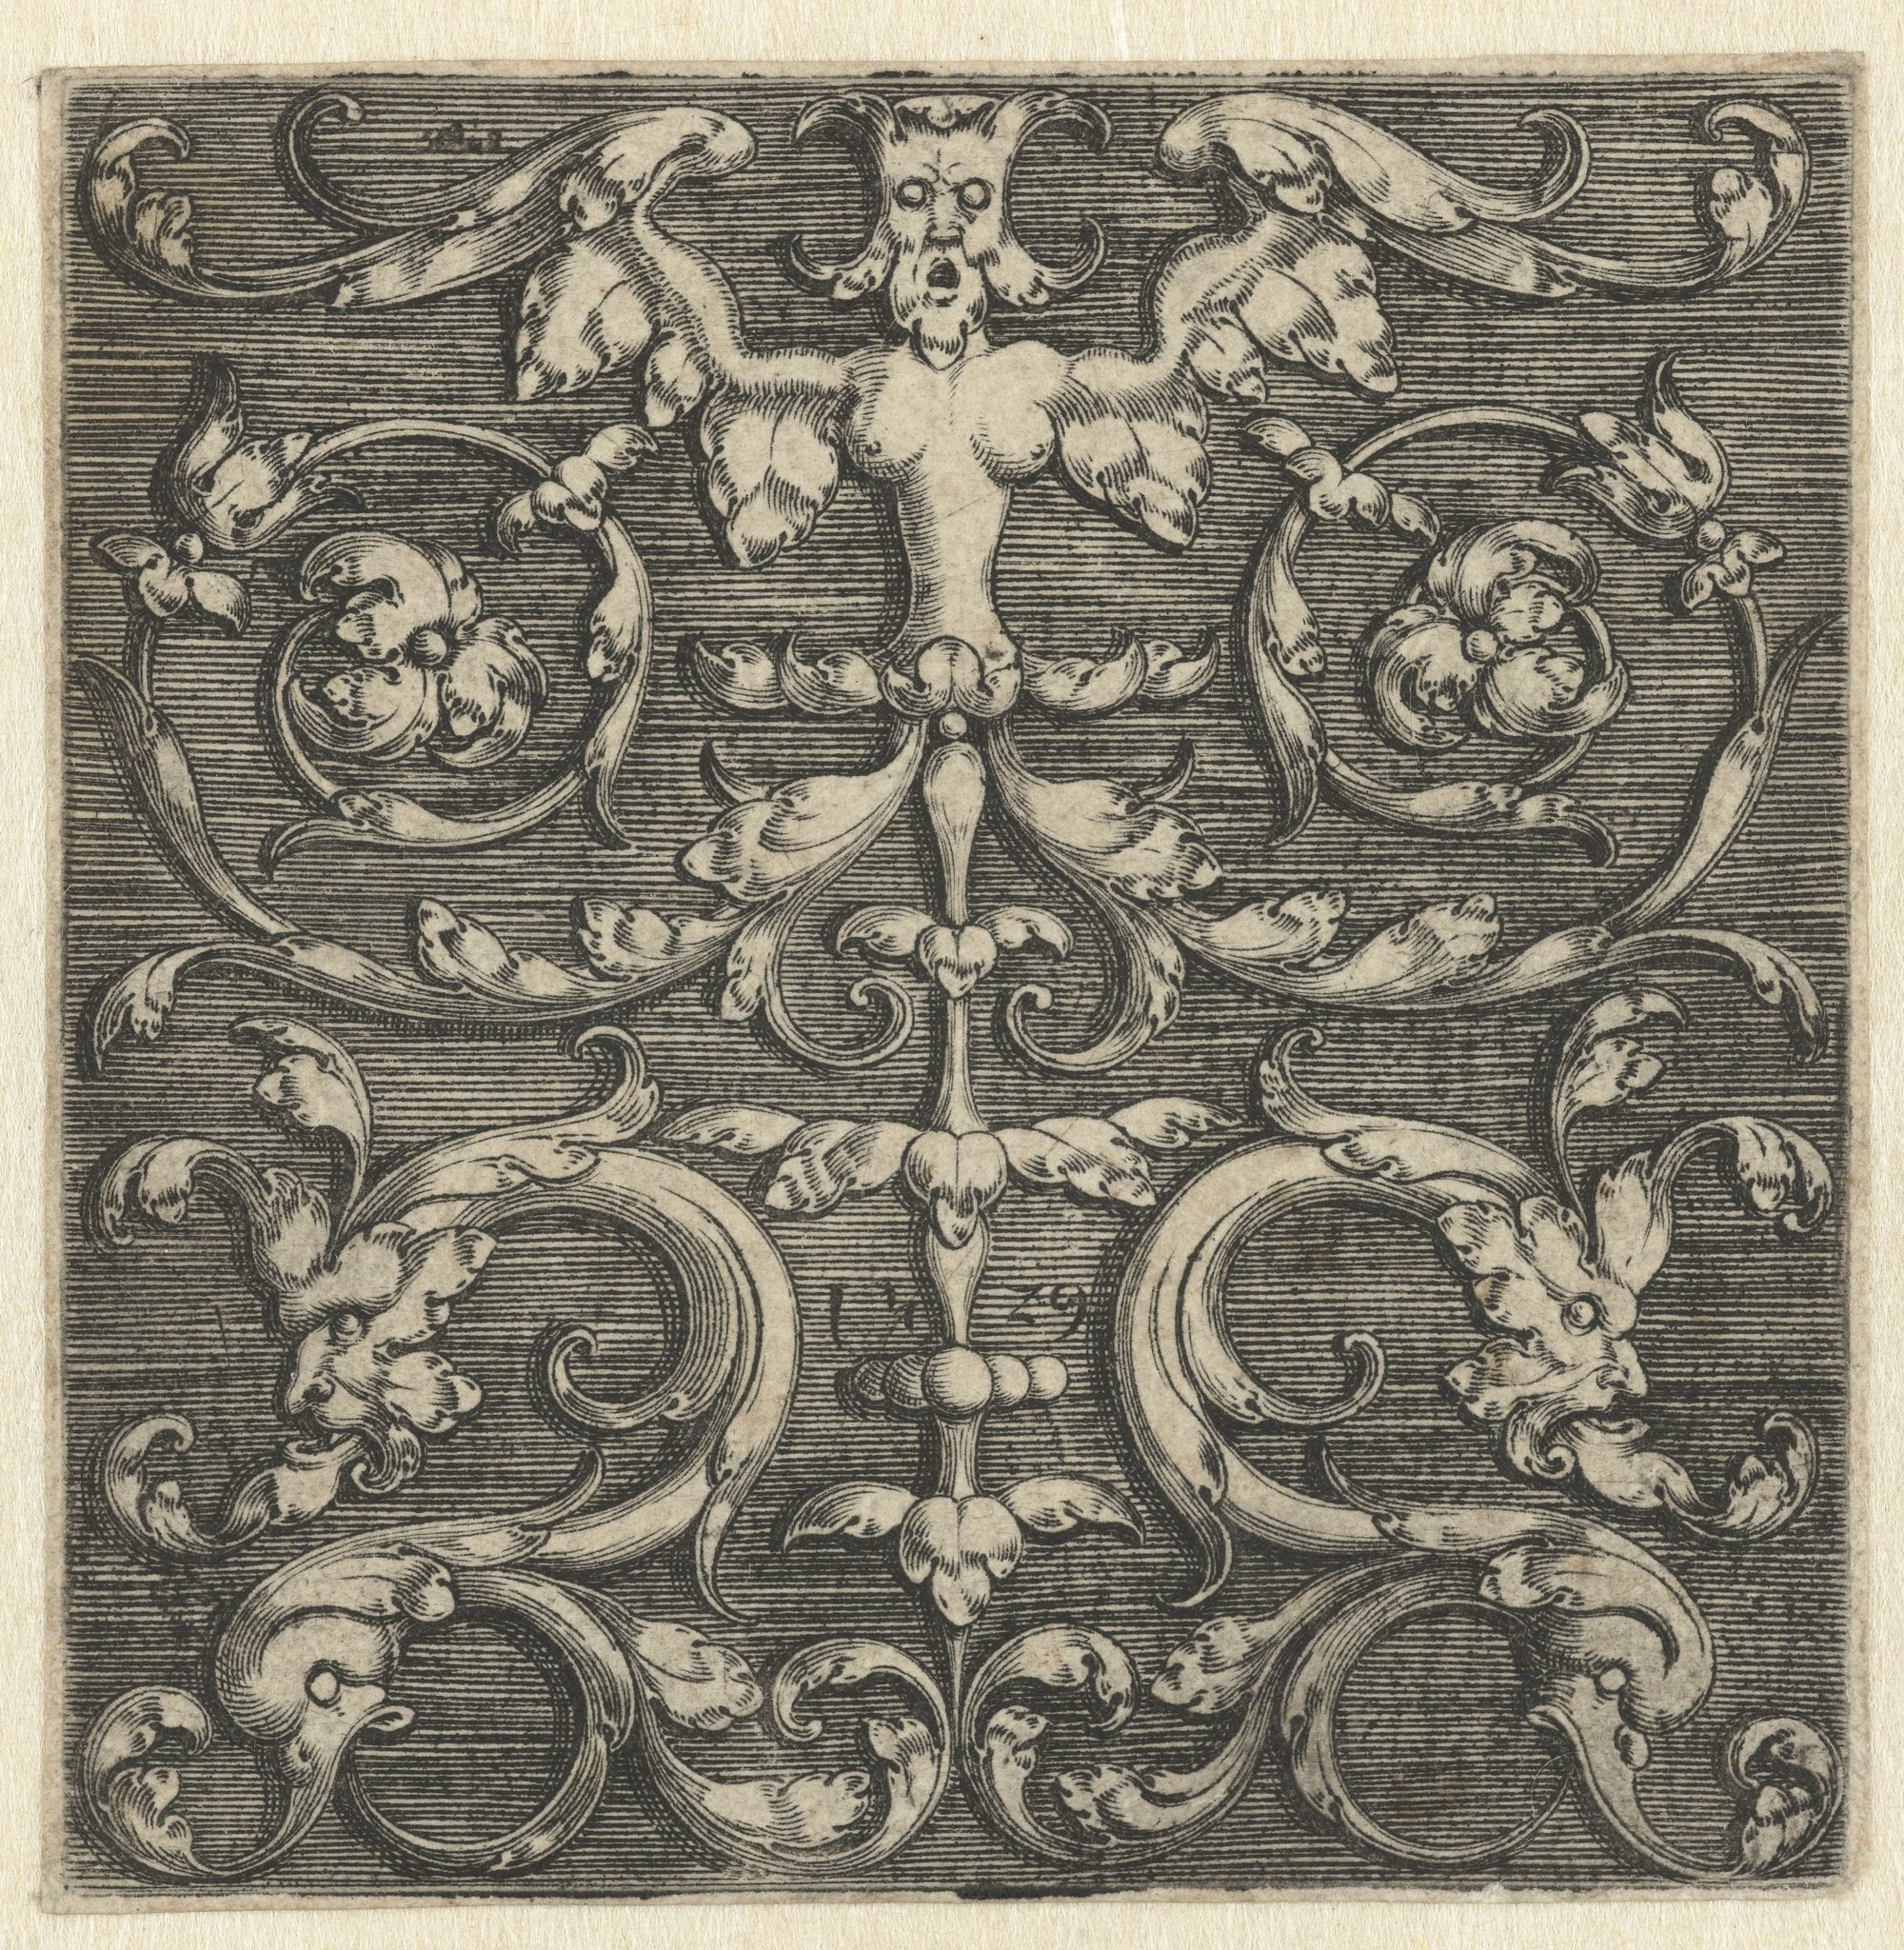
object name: ornament print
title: Ornament met symmetrisch figuur met vleugels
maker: monogrammist ig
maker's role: print maker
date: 1522-1530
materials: paper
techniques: engraving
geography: low countries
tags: animals (+ symmetrically placed ornamental animals)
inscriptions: collector's mark: Lugt 240